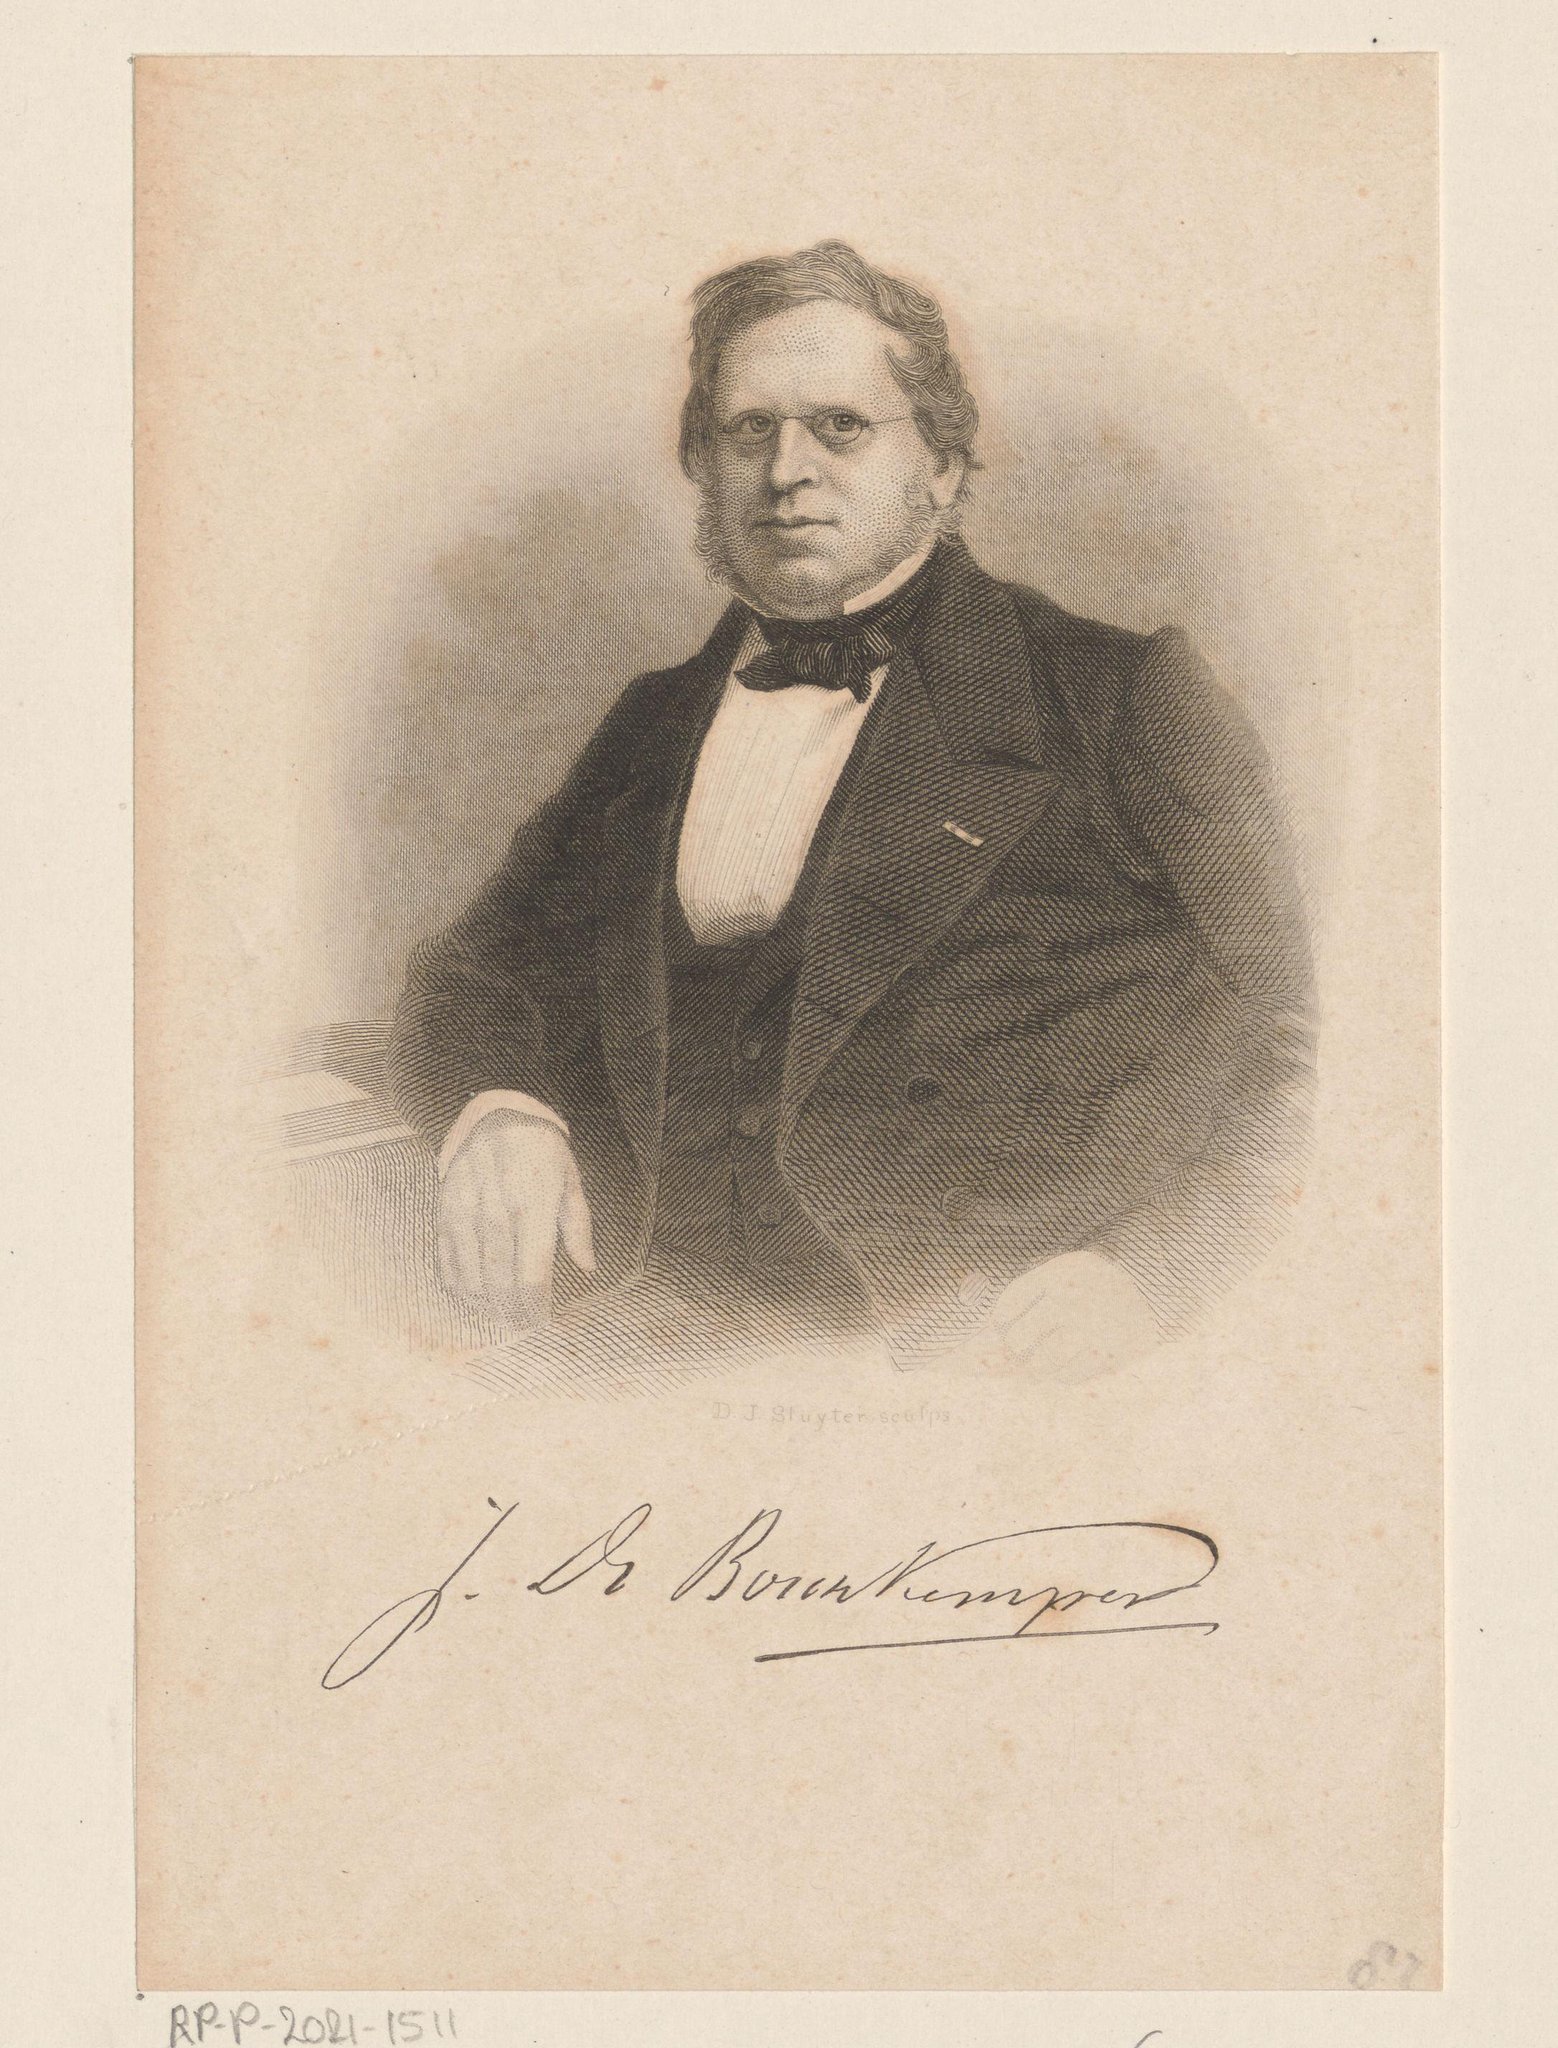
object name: print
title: Portret van Jeronimo de Bosch Kemper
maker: dirk jurriaan sluyter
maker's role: draughtsman, print maker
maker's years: 1811-1886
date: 1826-1886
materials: paper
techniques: engraving, etching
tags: historical persons, lawyer, attorney at law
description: Onder het portret een facsimile van de handtekening van de geportretteerde.